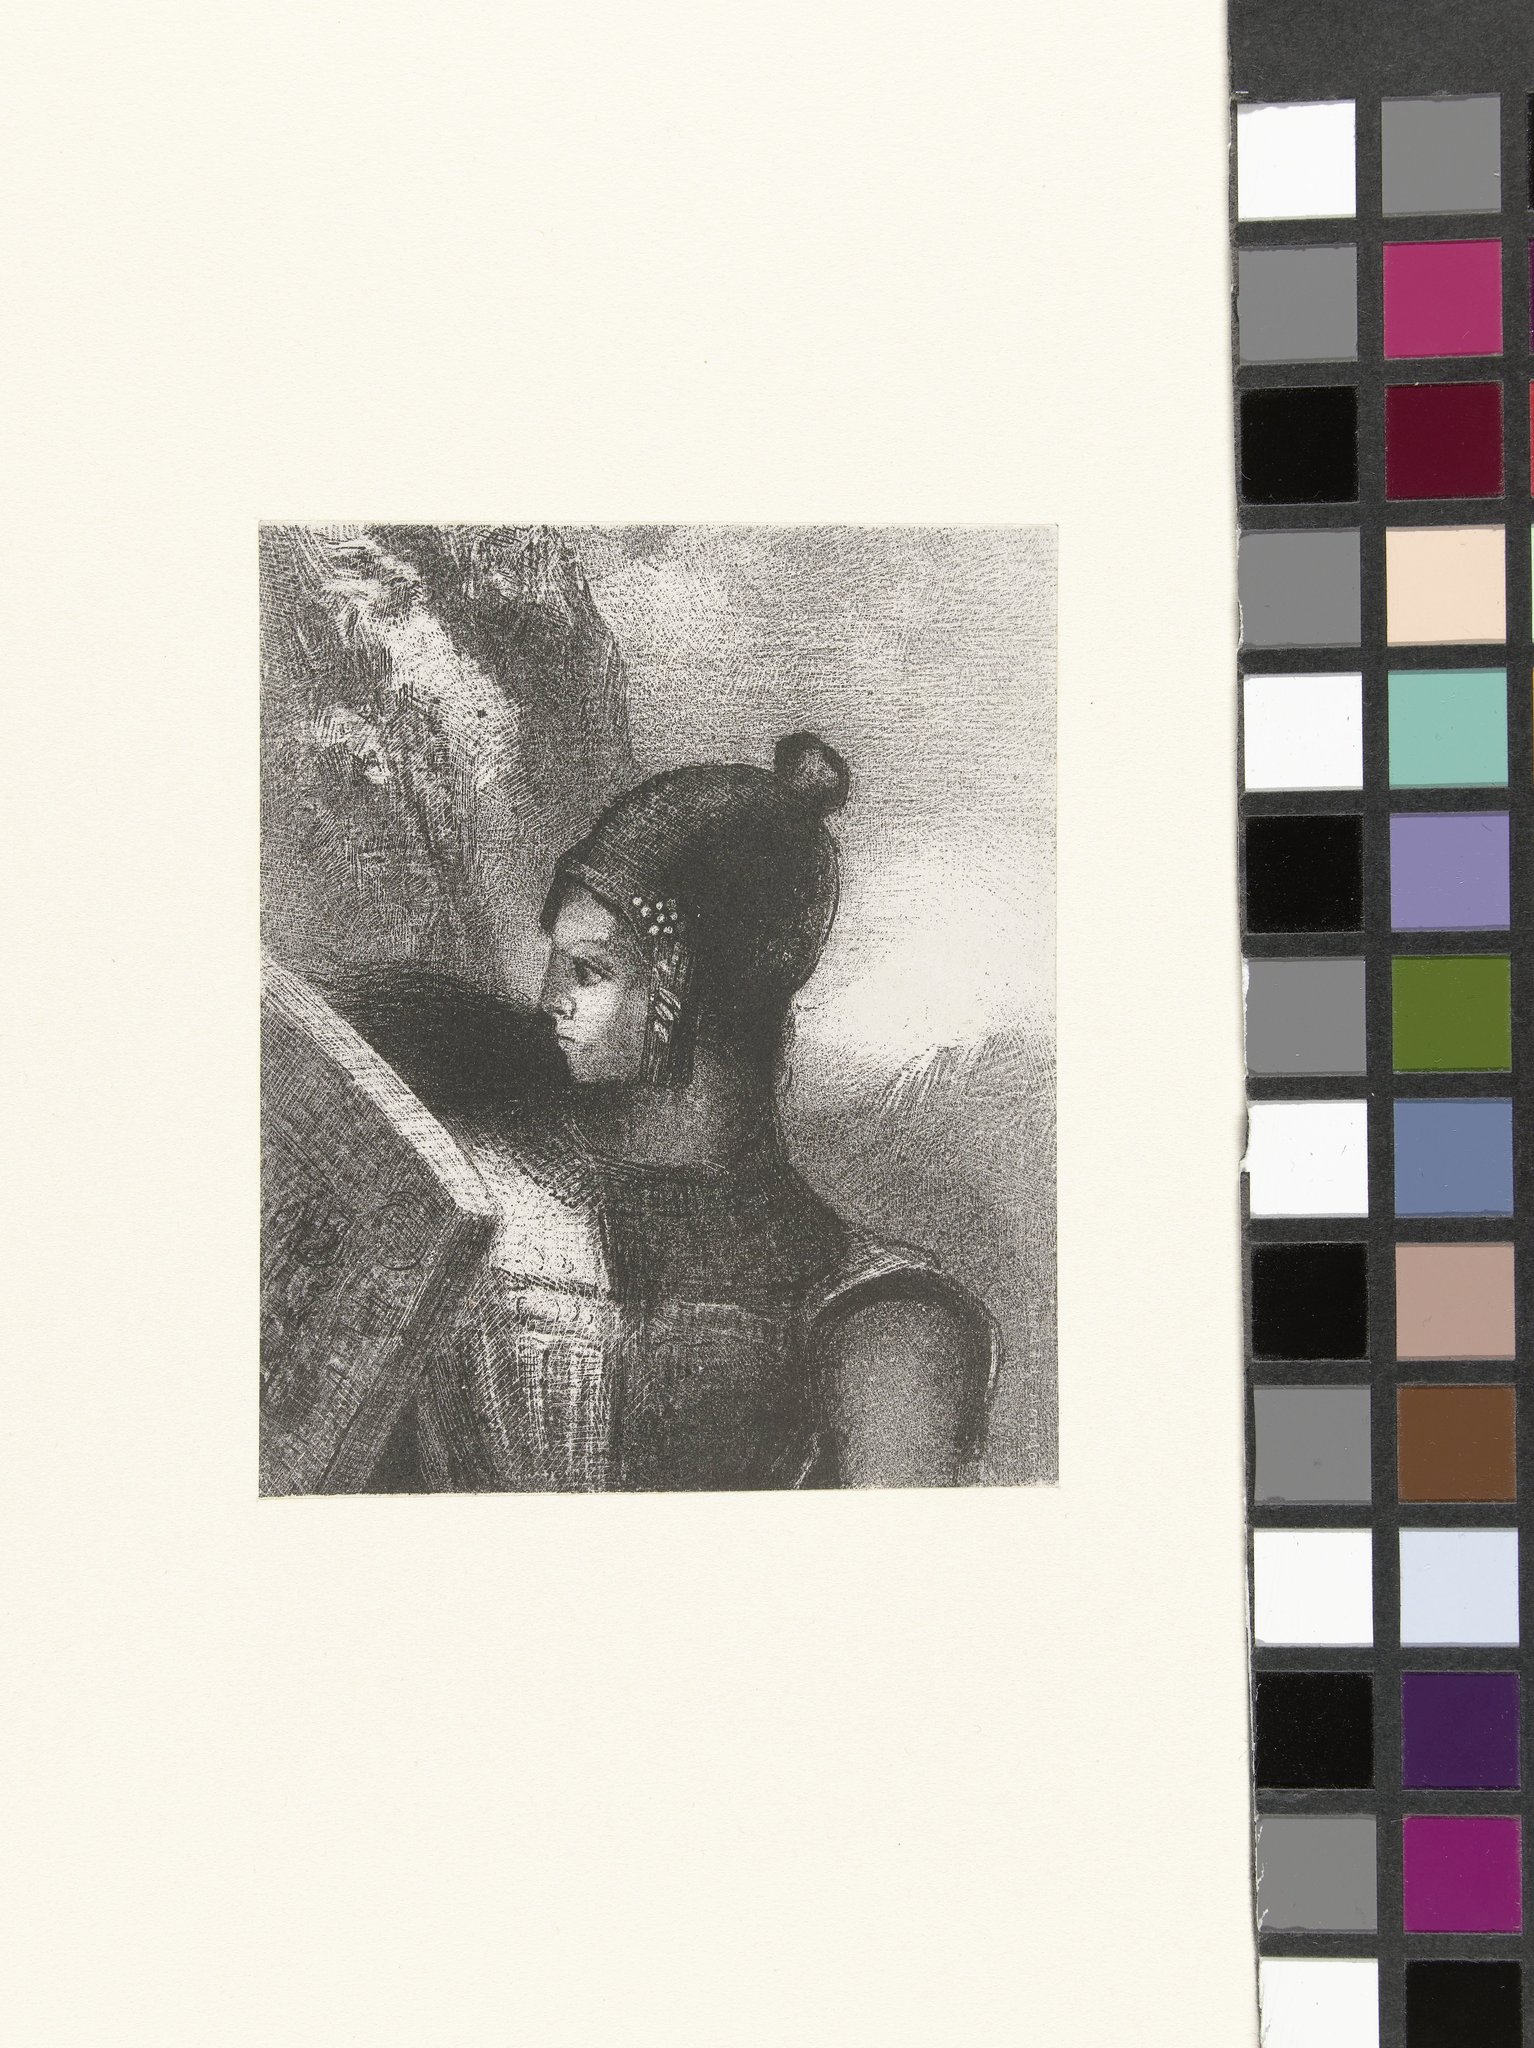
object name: print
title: Brunhilde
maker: odilon redon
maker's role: draughtsman, painter, print maker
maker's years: 1840-1916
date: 1885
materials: paper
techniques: lithograph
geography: paris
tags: brunhild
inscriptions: collector's mark: Lugt 2228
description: Lithografie werd geleverd bij een editie van Revue Wagnérienne in 1885.